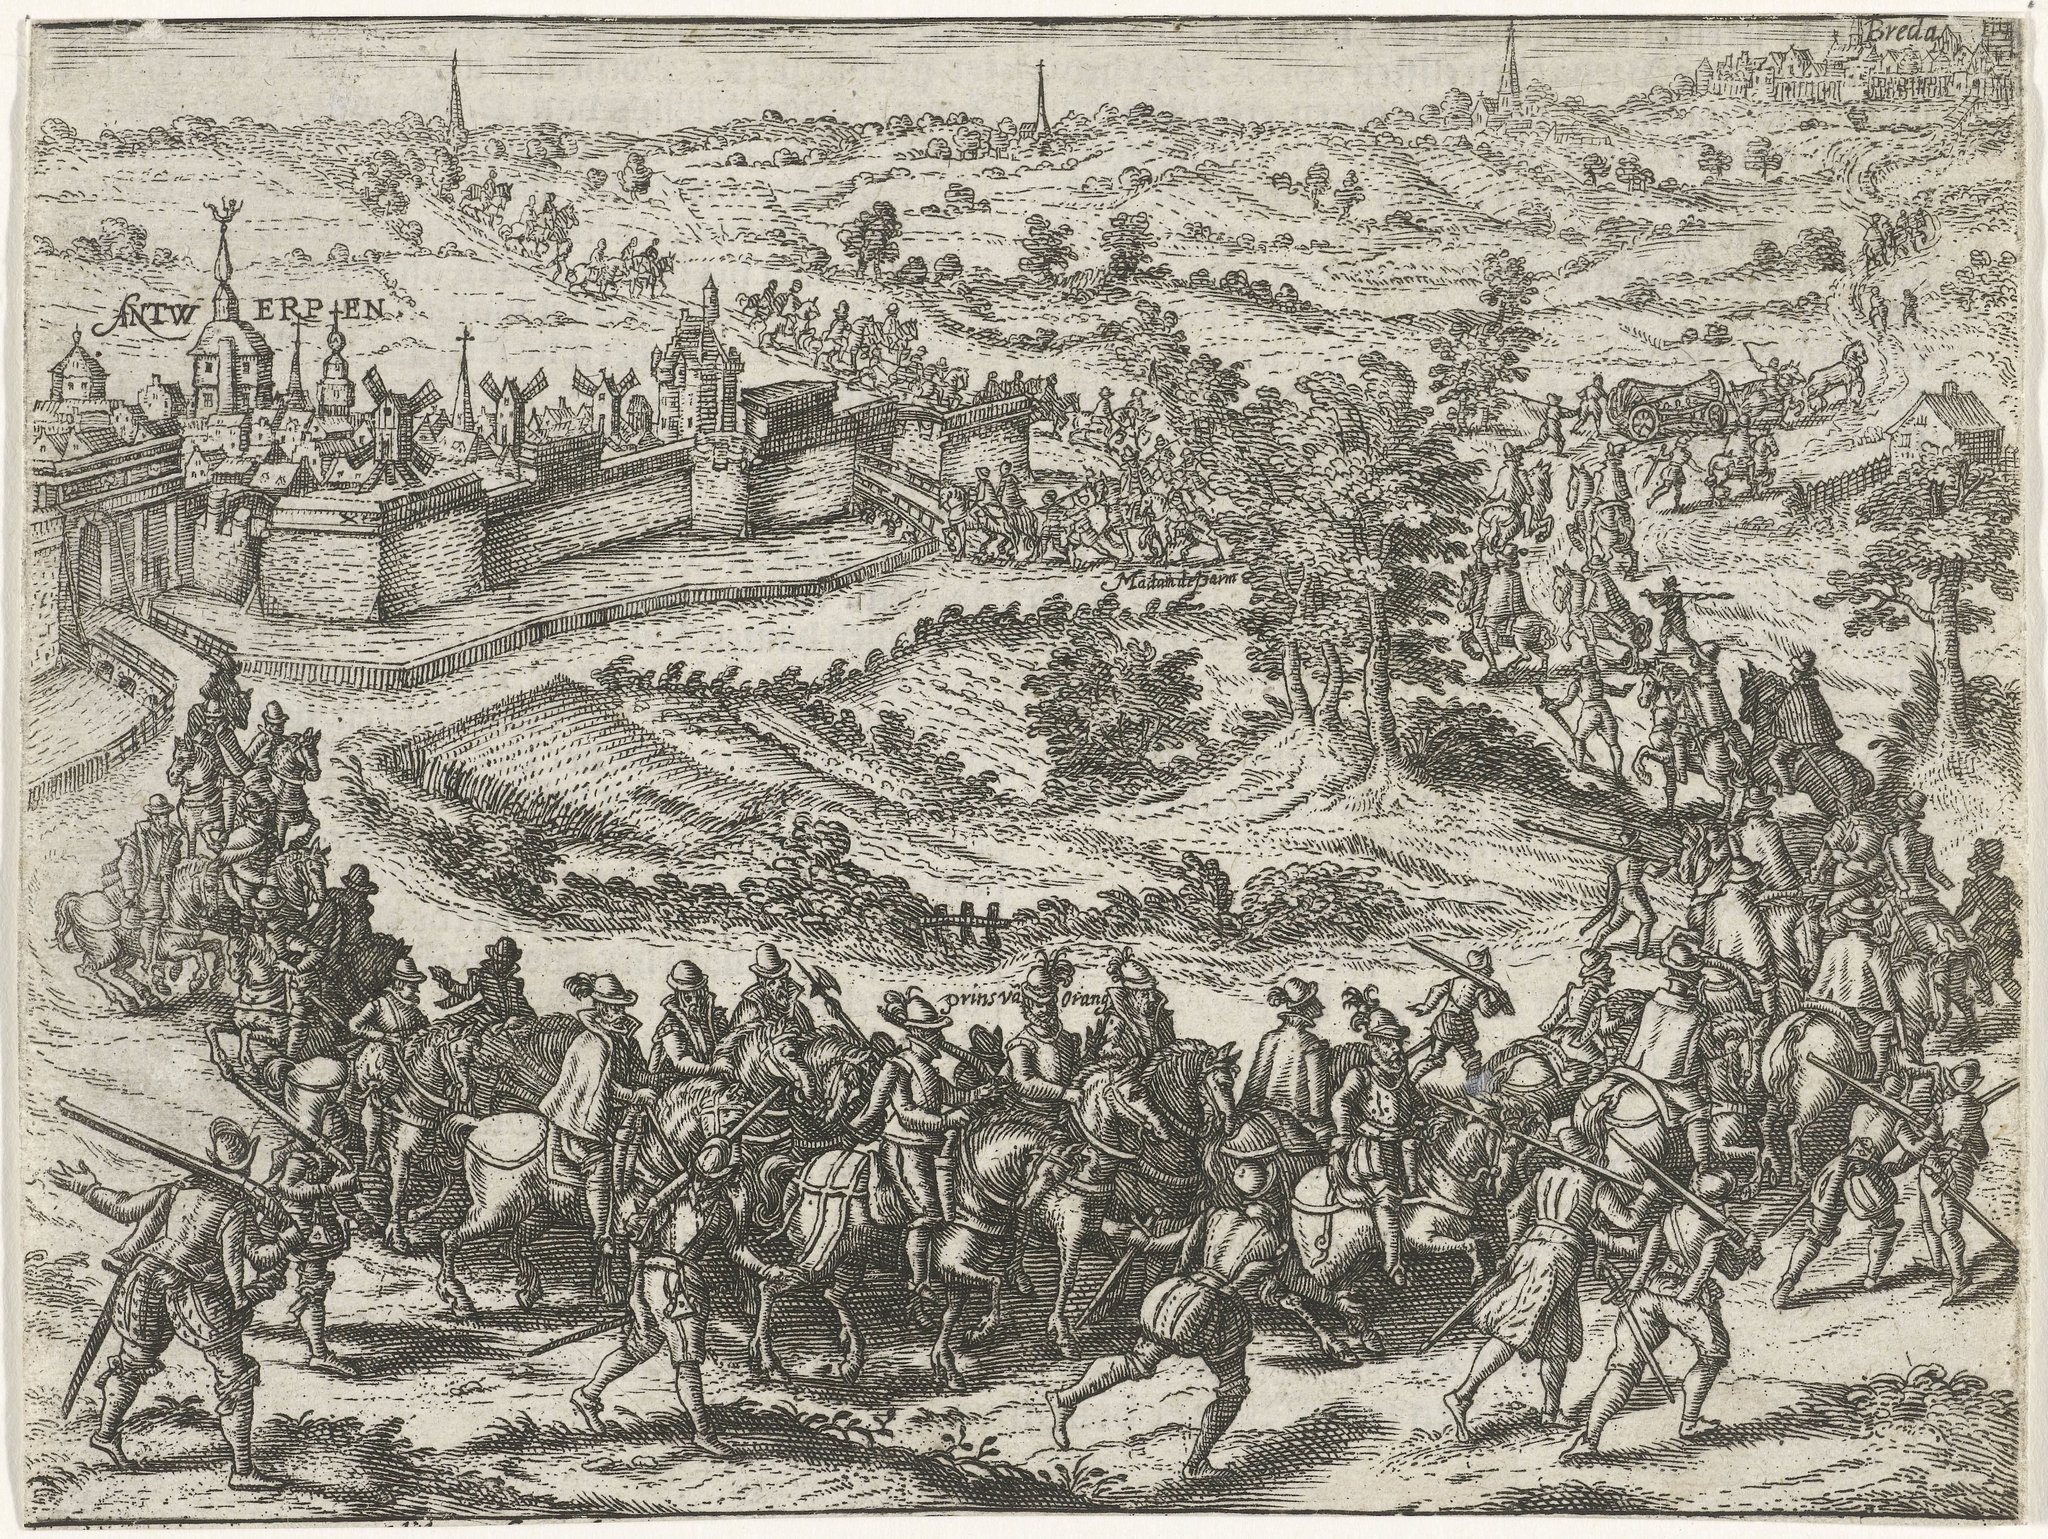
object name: print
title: Prins van Oranje vertrekt naar Duitsland, 1567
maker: Anonymous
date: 1613-1615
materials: paper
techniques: engraving, etching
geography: northern netherlands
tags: delft, william i (prince of orange), antwerp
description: De prins van Oranje vertrekt uit Antwerpen naar Duitsland, 21 april 1567. Stoet met de prins trekt door het land vanuit Antwerpen richting Breda. Bedrukt op achterzijde met tekst in het Nederlands.